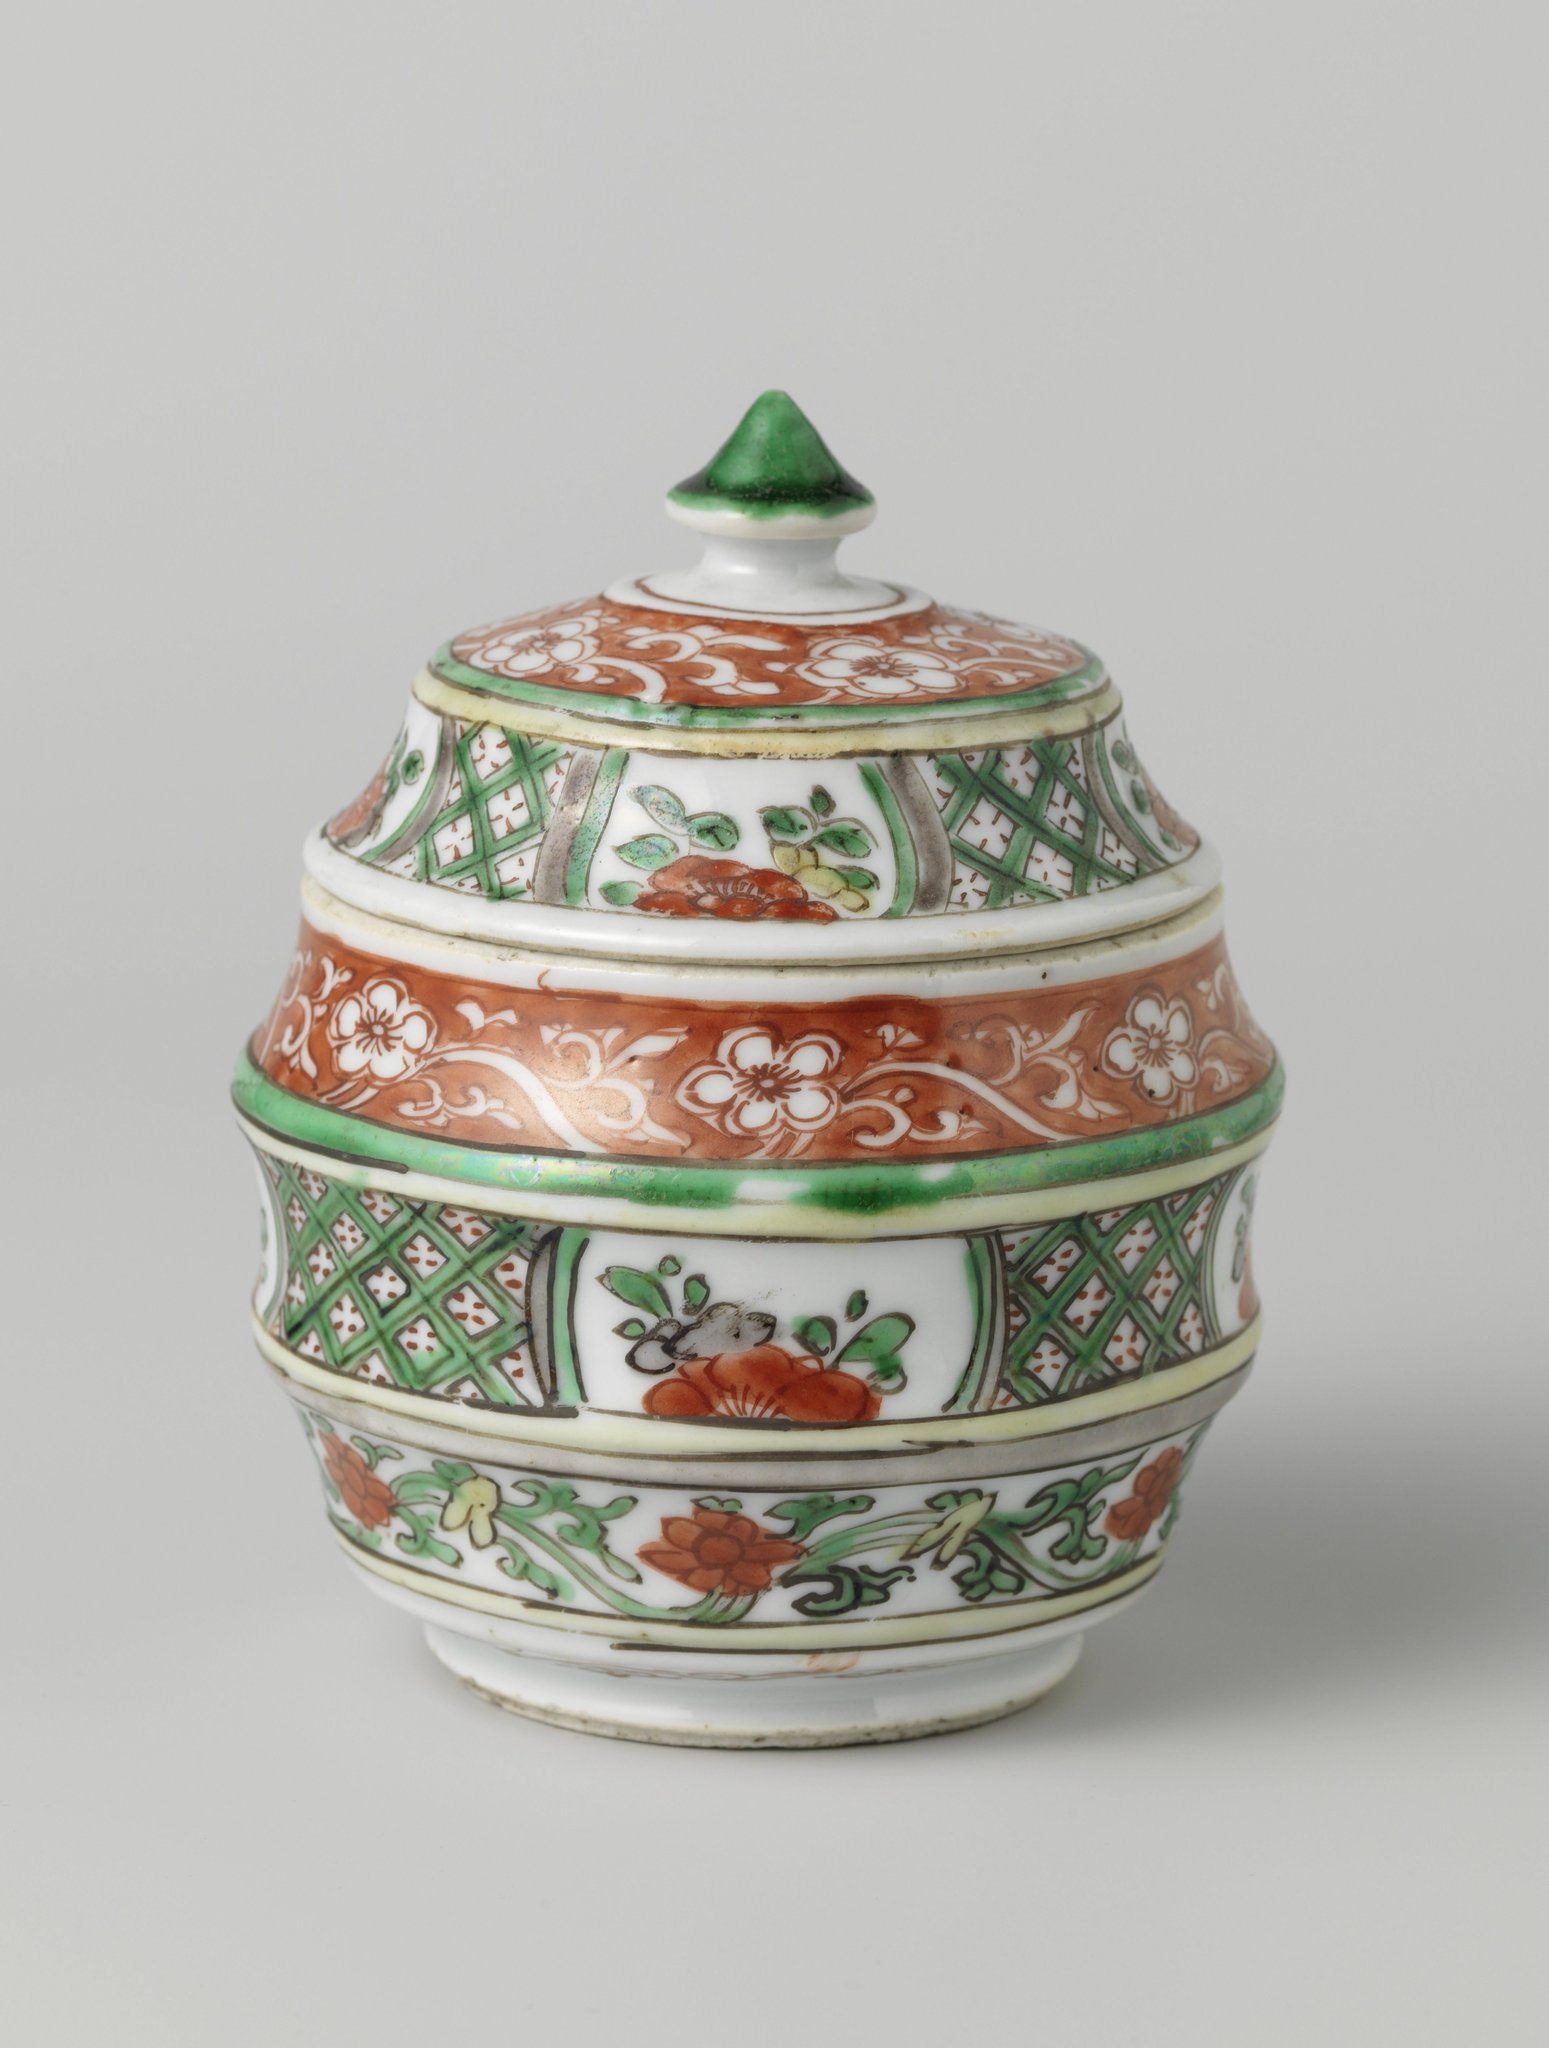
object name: covered jar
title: Barrel-shaped covered jar with flower scrolls and geometric patterns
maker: Anonymous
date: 1700-1724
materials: glaze, paint, porcelain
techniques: firing, forming, vitrification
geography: china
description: Tonvormige pot van porselein opgebouwd uit drie concave lagen boven elkaar, beschilderd op het glazuur in rood, groen, geel, aubergine en zwart met bloemranken en geometrische motieven. Elke laag heeft een andere decoratie: de onderste is gevuld met lotusranken, de middelste met geometrische motieven onderbroken door cartouches met een bloemtak, de bovenste met bloemranken uitgespaard in een rode grond; rond de voet is krulwerk aangebracht. Famille verte.